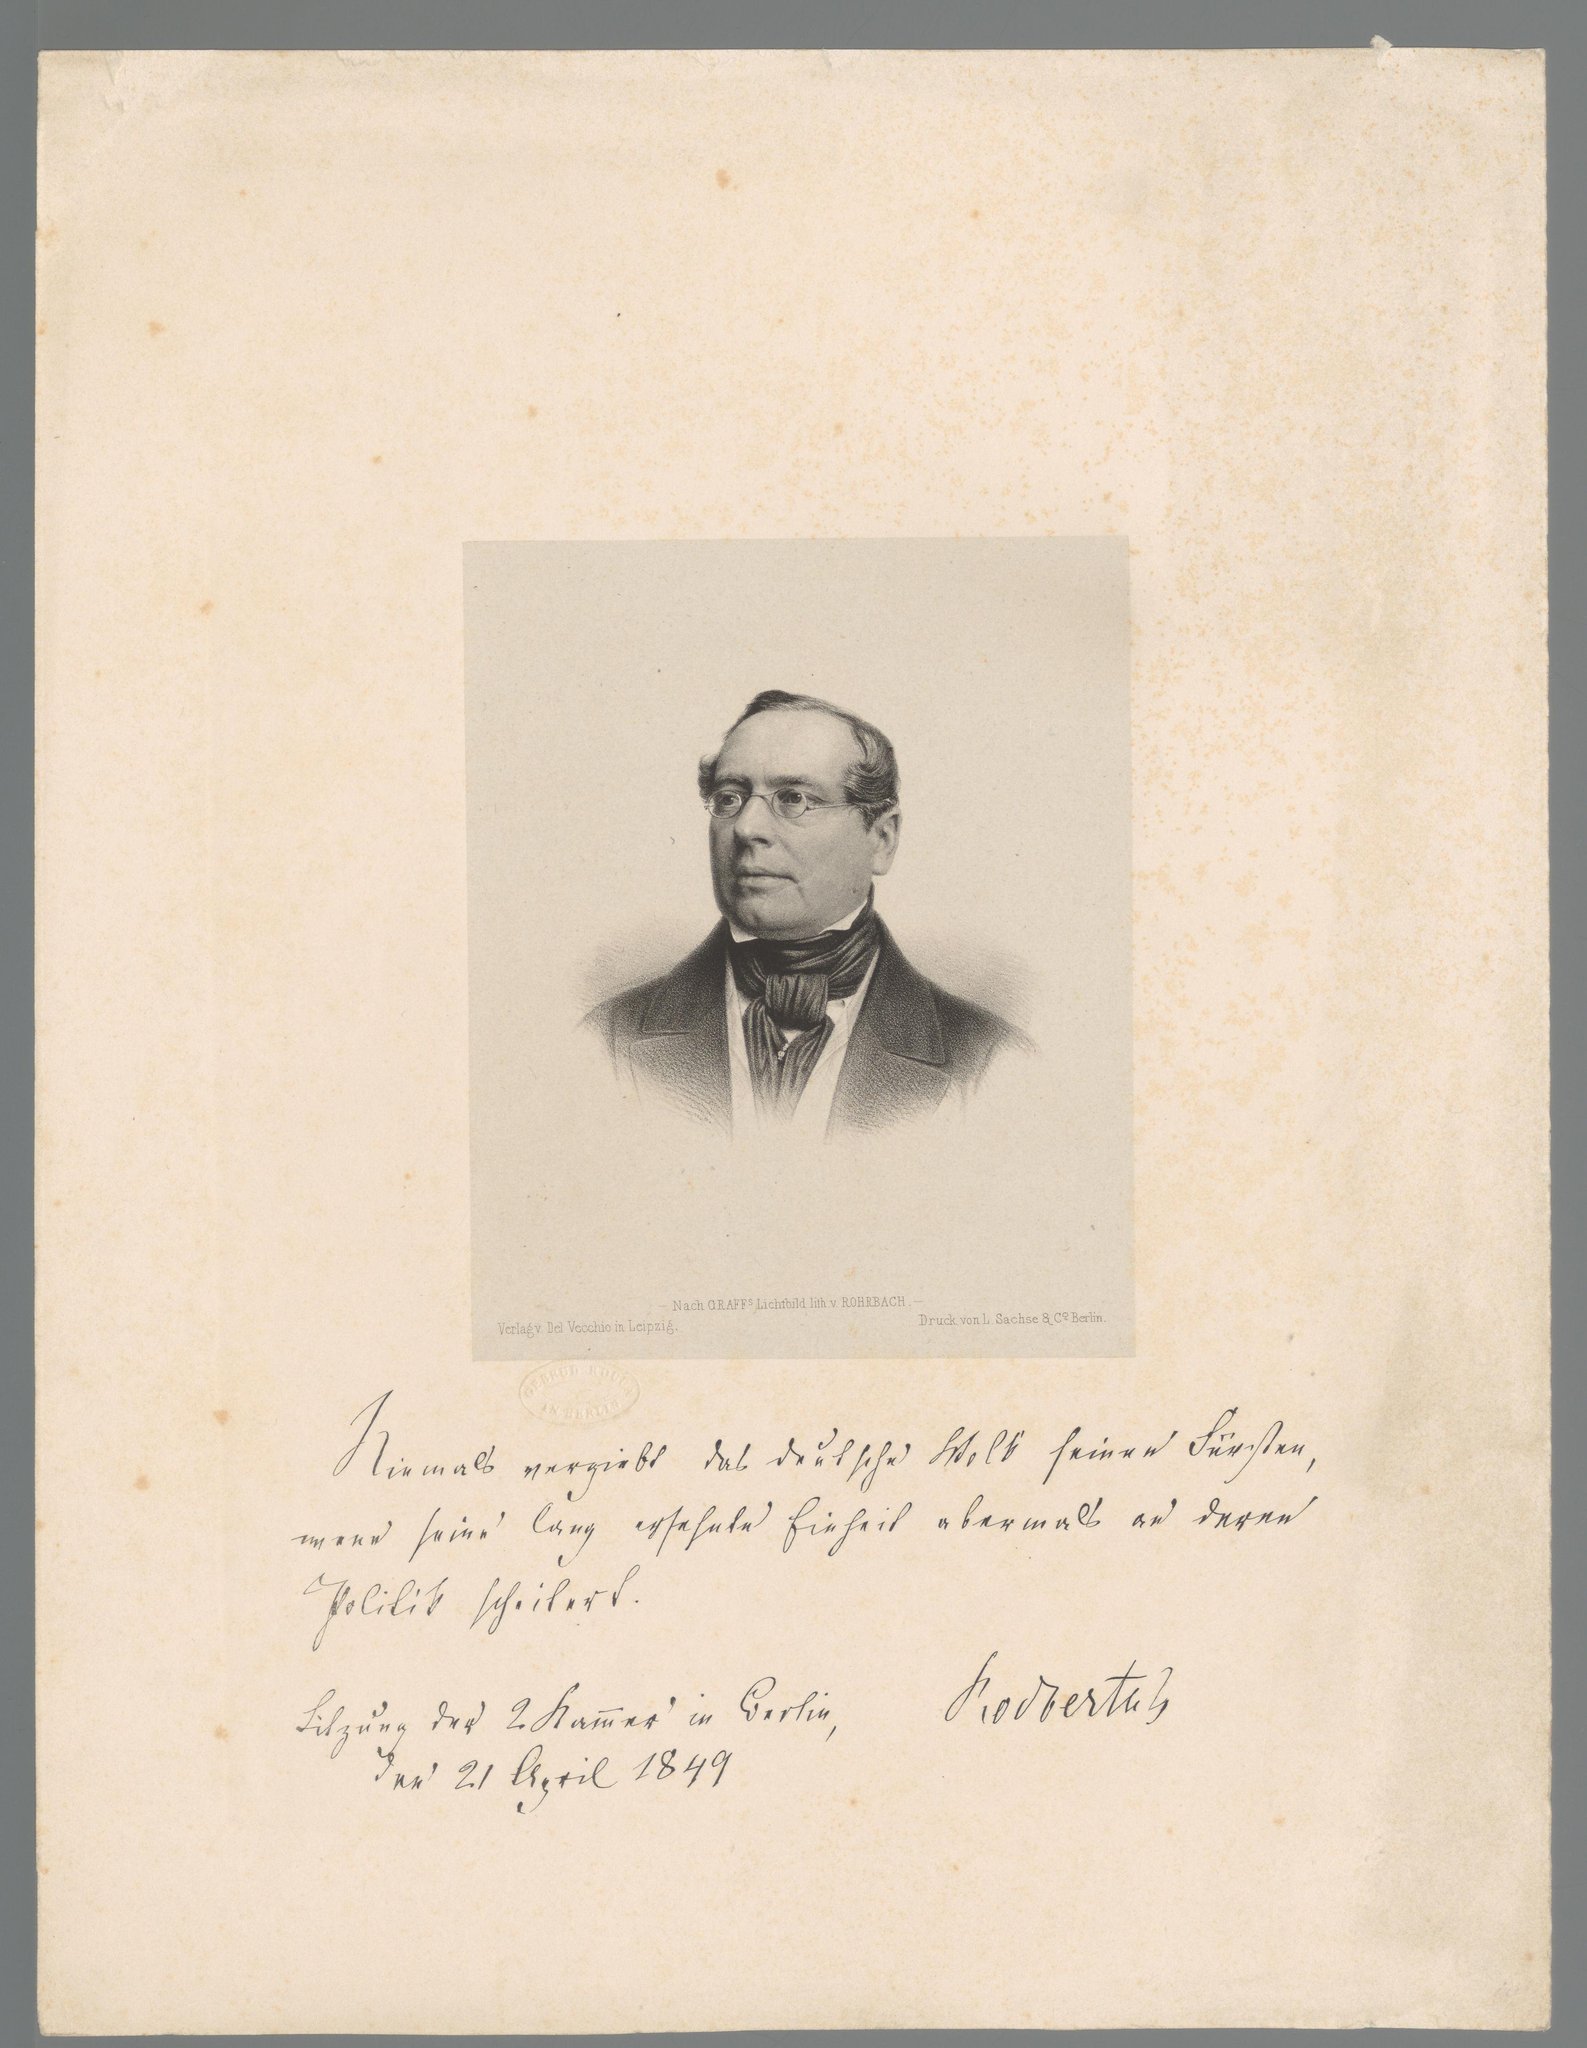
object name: print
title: Portret van Johann Karl Rodbertus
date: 1849-1862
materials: paper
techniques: lithograph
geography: berlin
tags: historical persons, politician, e.g. party leader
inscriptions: collector's mark: Lugt 2228, check stamp: Lugt 2141c